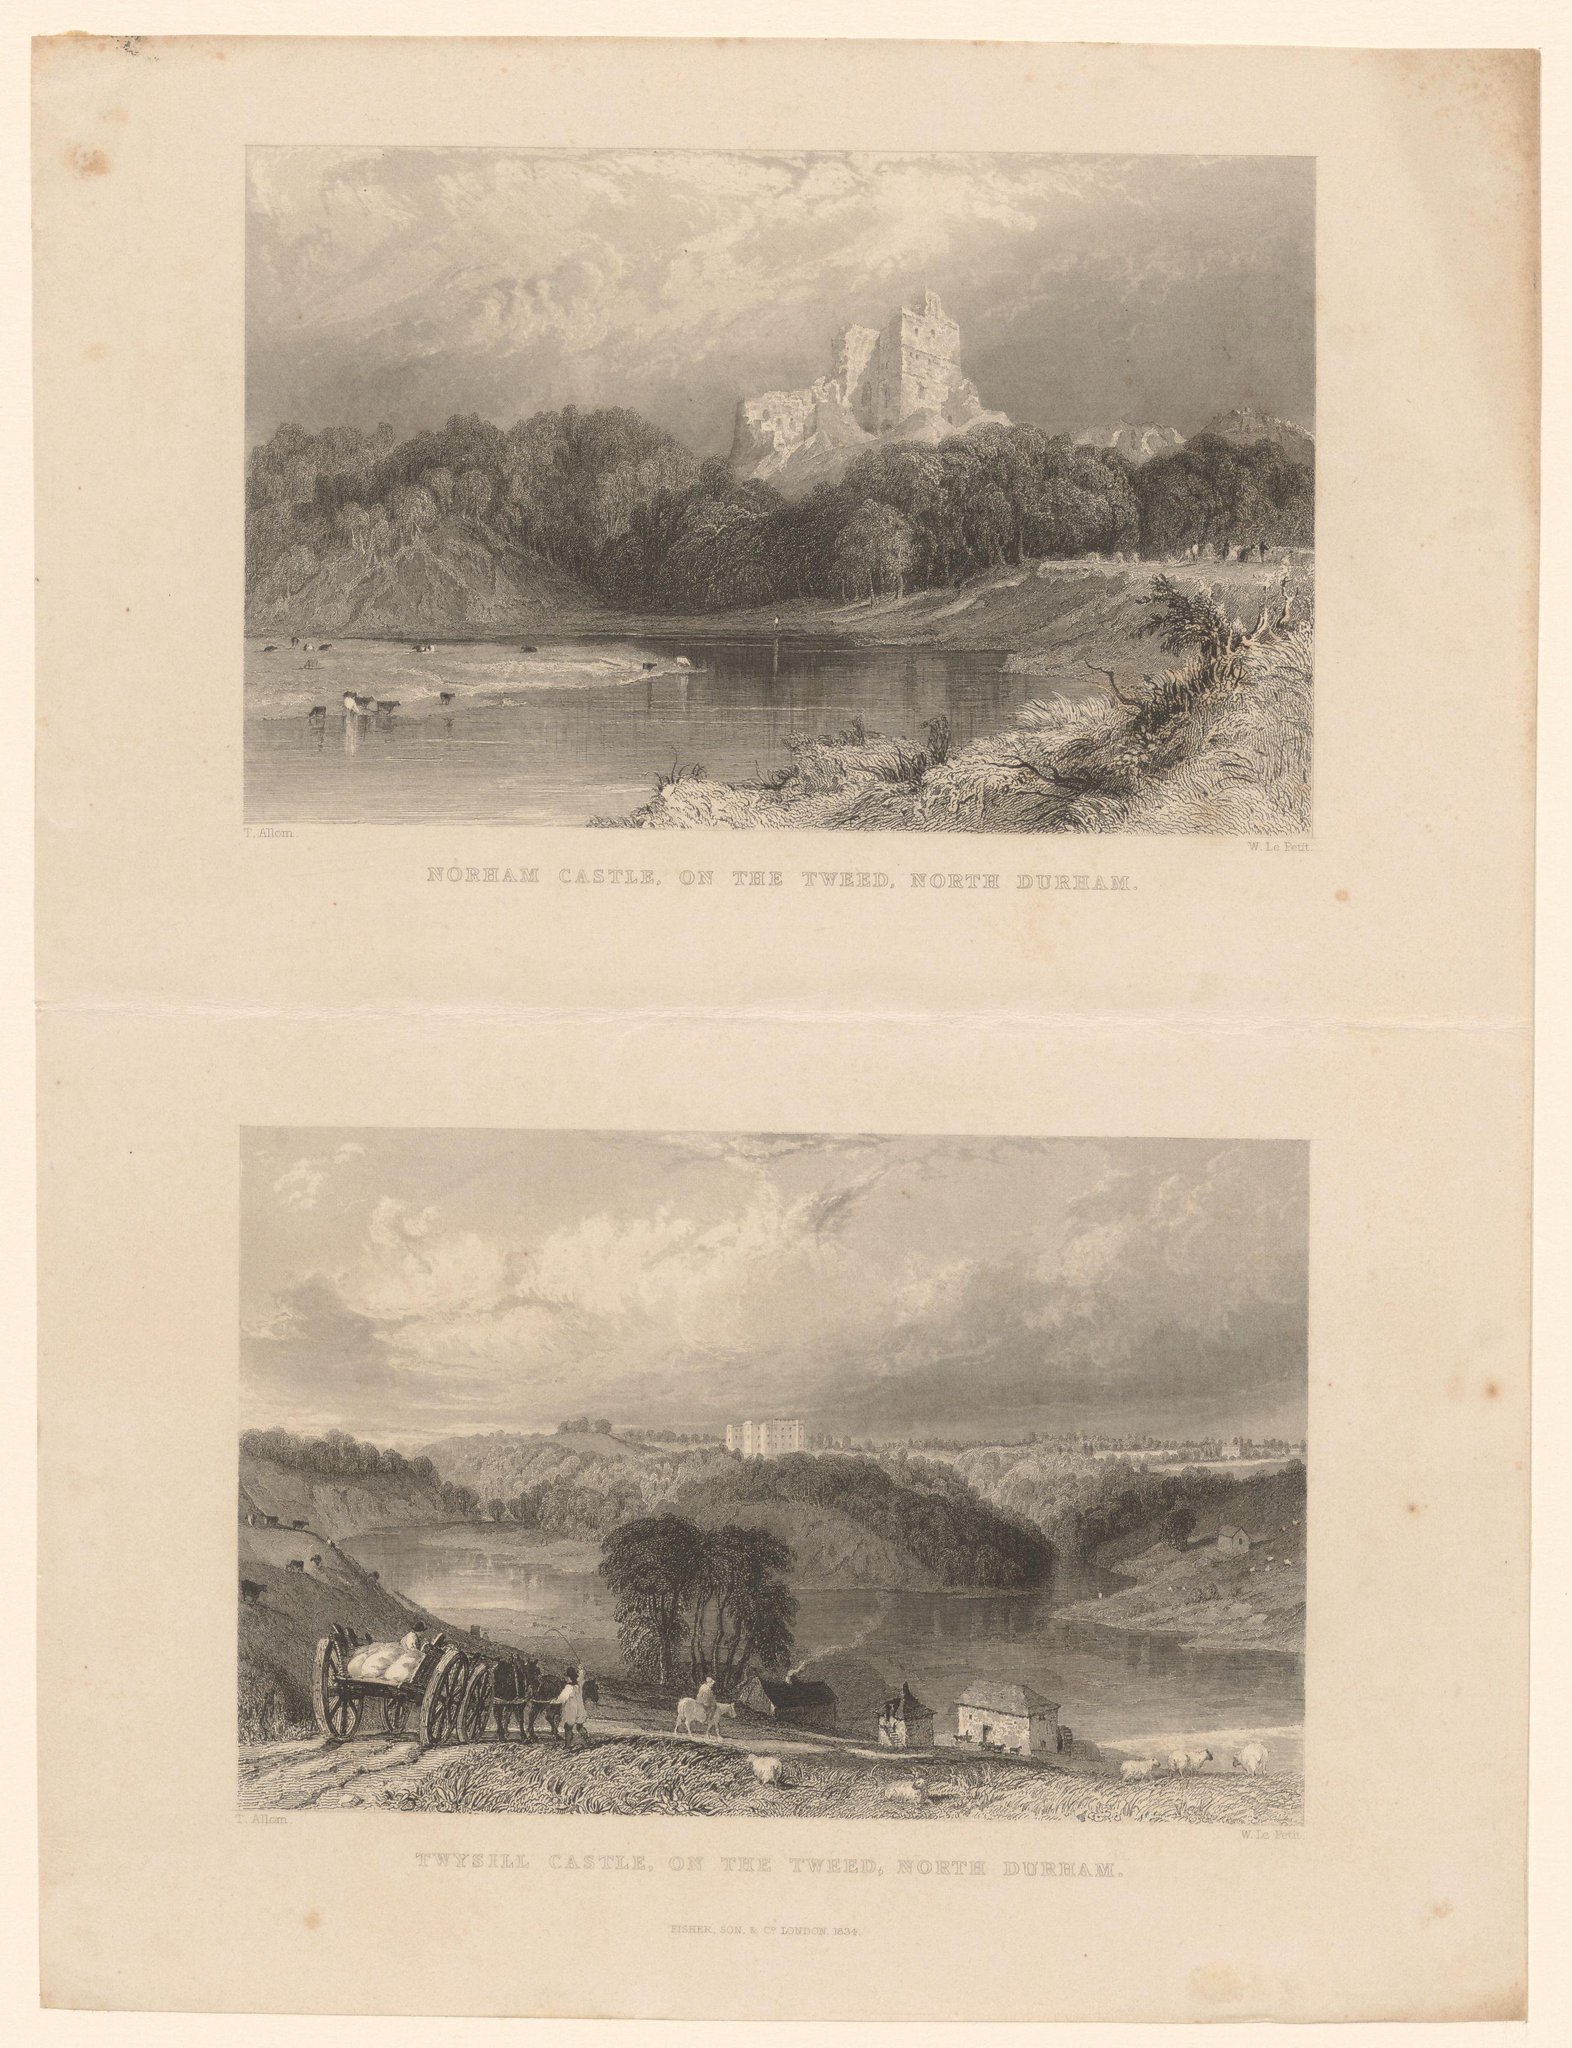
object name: print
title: Norham Castle, on the Tweed, North Durham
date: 1834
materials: paper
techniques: engraving, etching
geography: london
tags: castle, bridge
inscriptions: collector's mark: Lugt 2228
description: Tekst in het Engels in de ondermarges van beide voorstellingen.